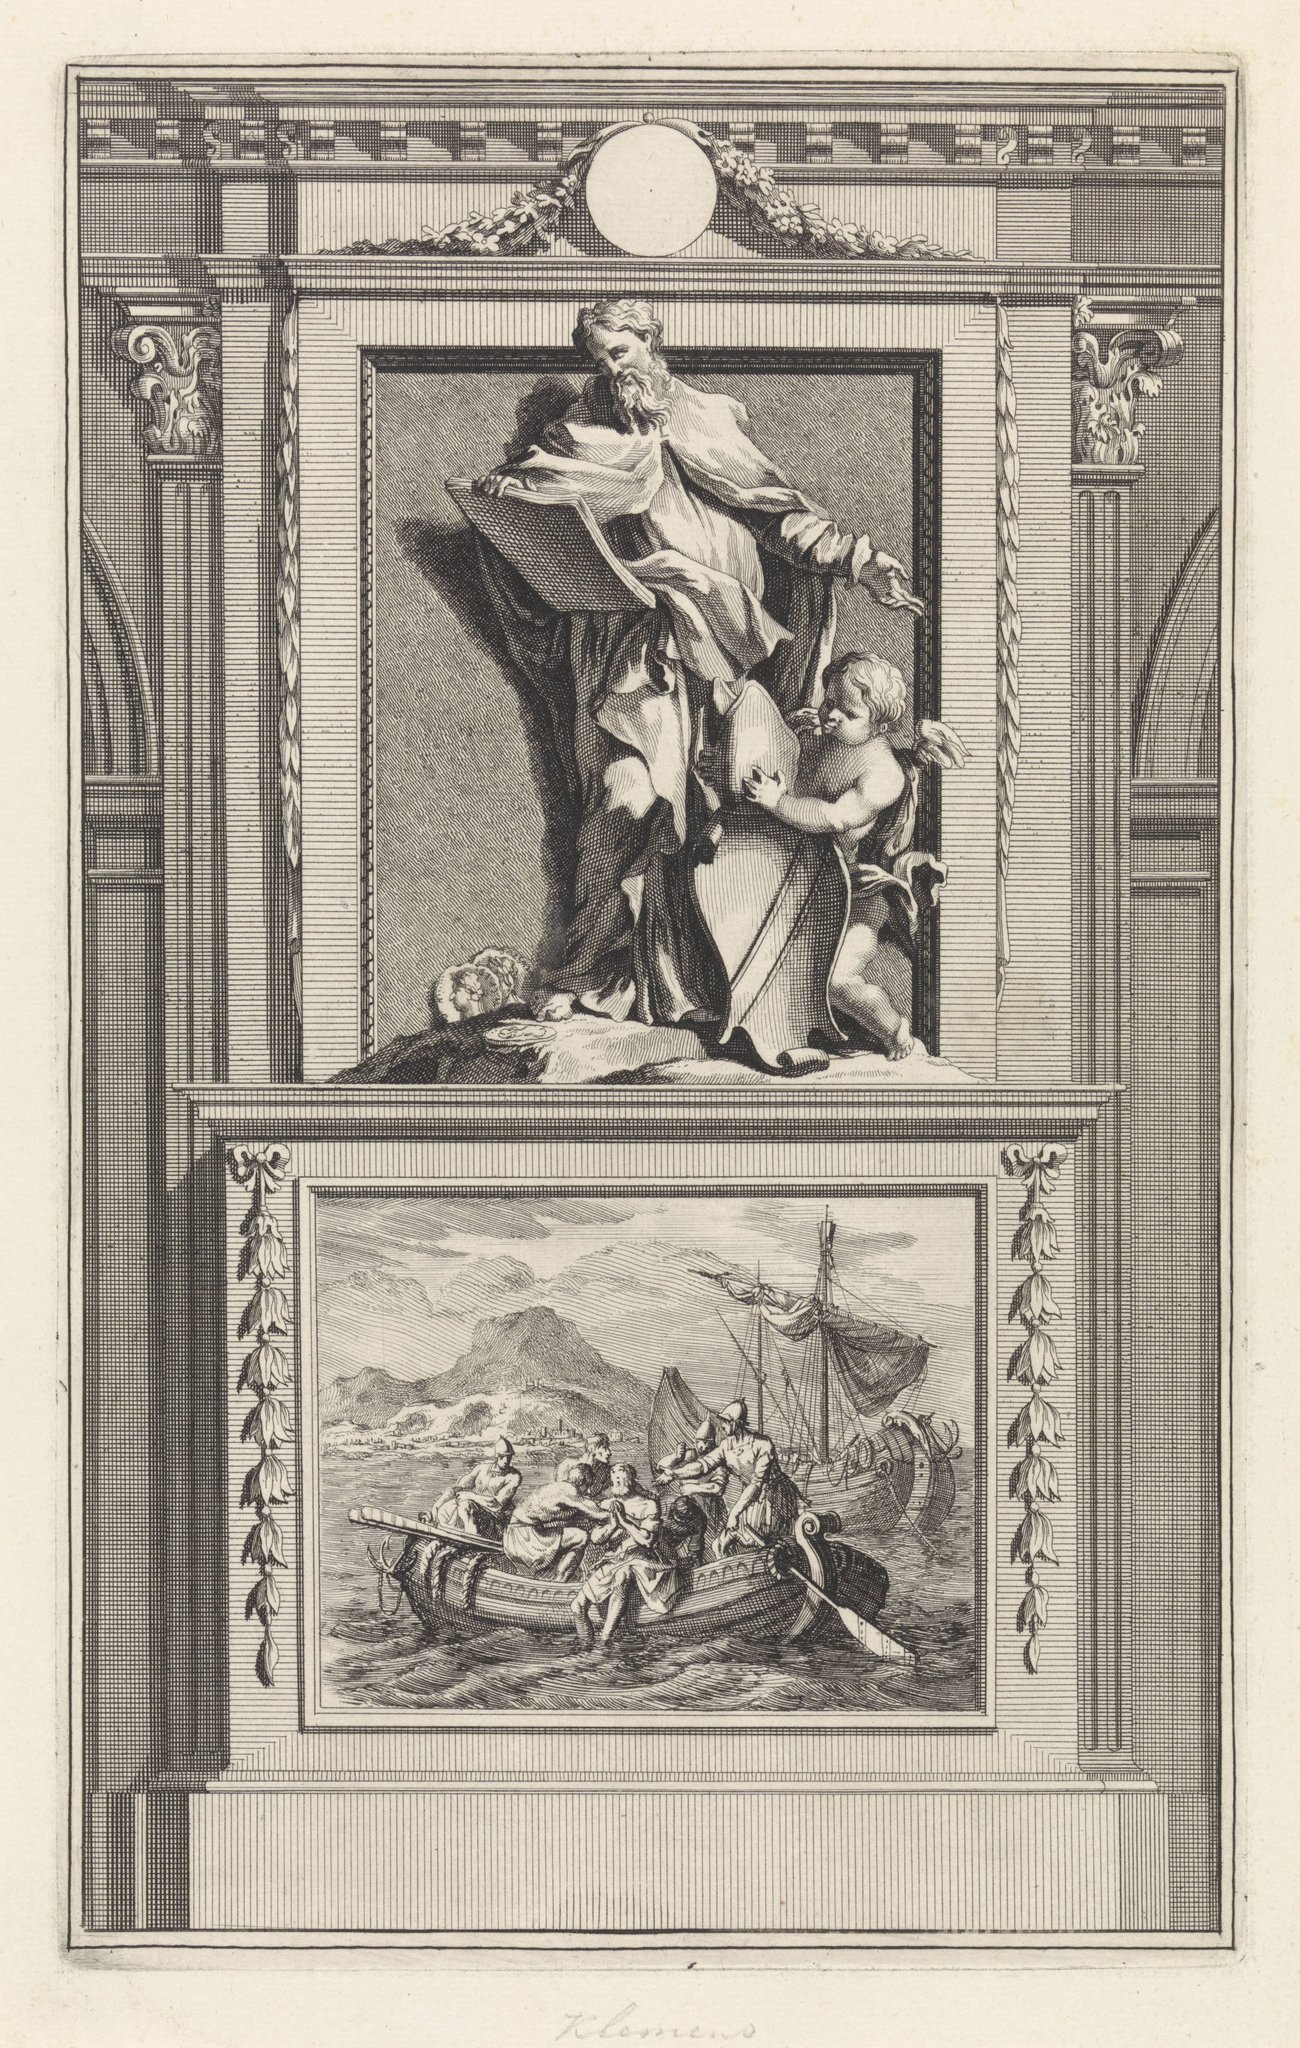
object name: print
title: H. Clemens van Rome, kerkvader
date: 1698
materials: paper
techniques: engraving, etching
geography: amsterdam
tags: clement i, pope and martyr; possible attributes: anchor, lamb, millstone, trireme, st. clement is thrown off a cliff (or from a boat) into the sea with an anchor (or a millstone) tied to his neck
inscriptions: collector's mark: Lugt 2228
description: De heilige kerkvader Clemens van Rome bestudeert een geschrift terwijl een engel voor hem een wapenschild met een bisschopsmijter tooit. Clemens staat op een sokkel. Op de voorzijde de scène waarin hij vastgebonden aan een anker in zee wordt geworpen.